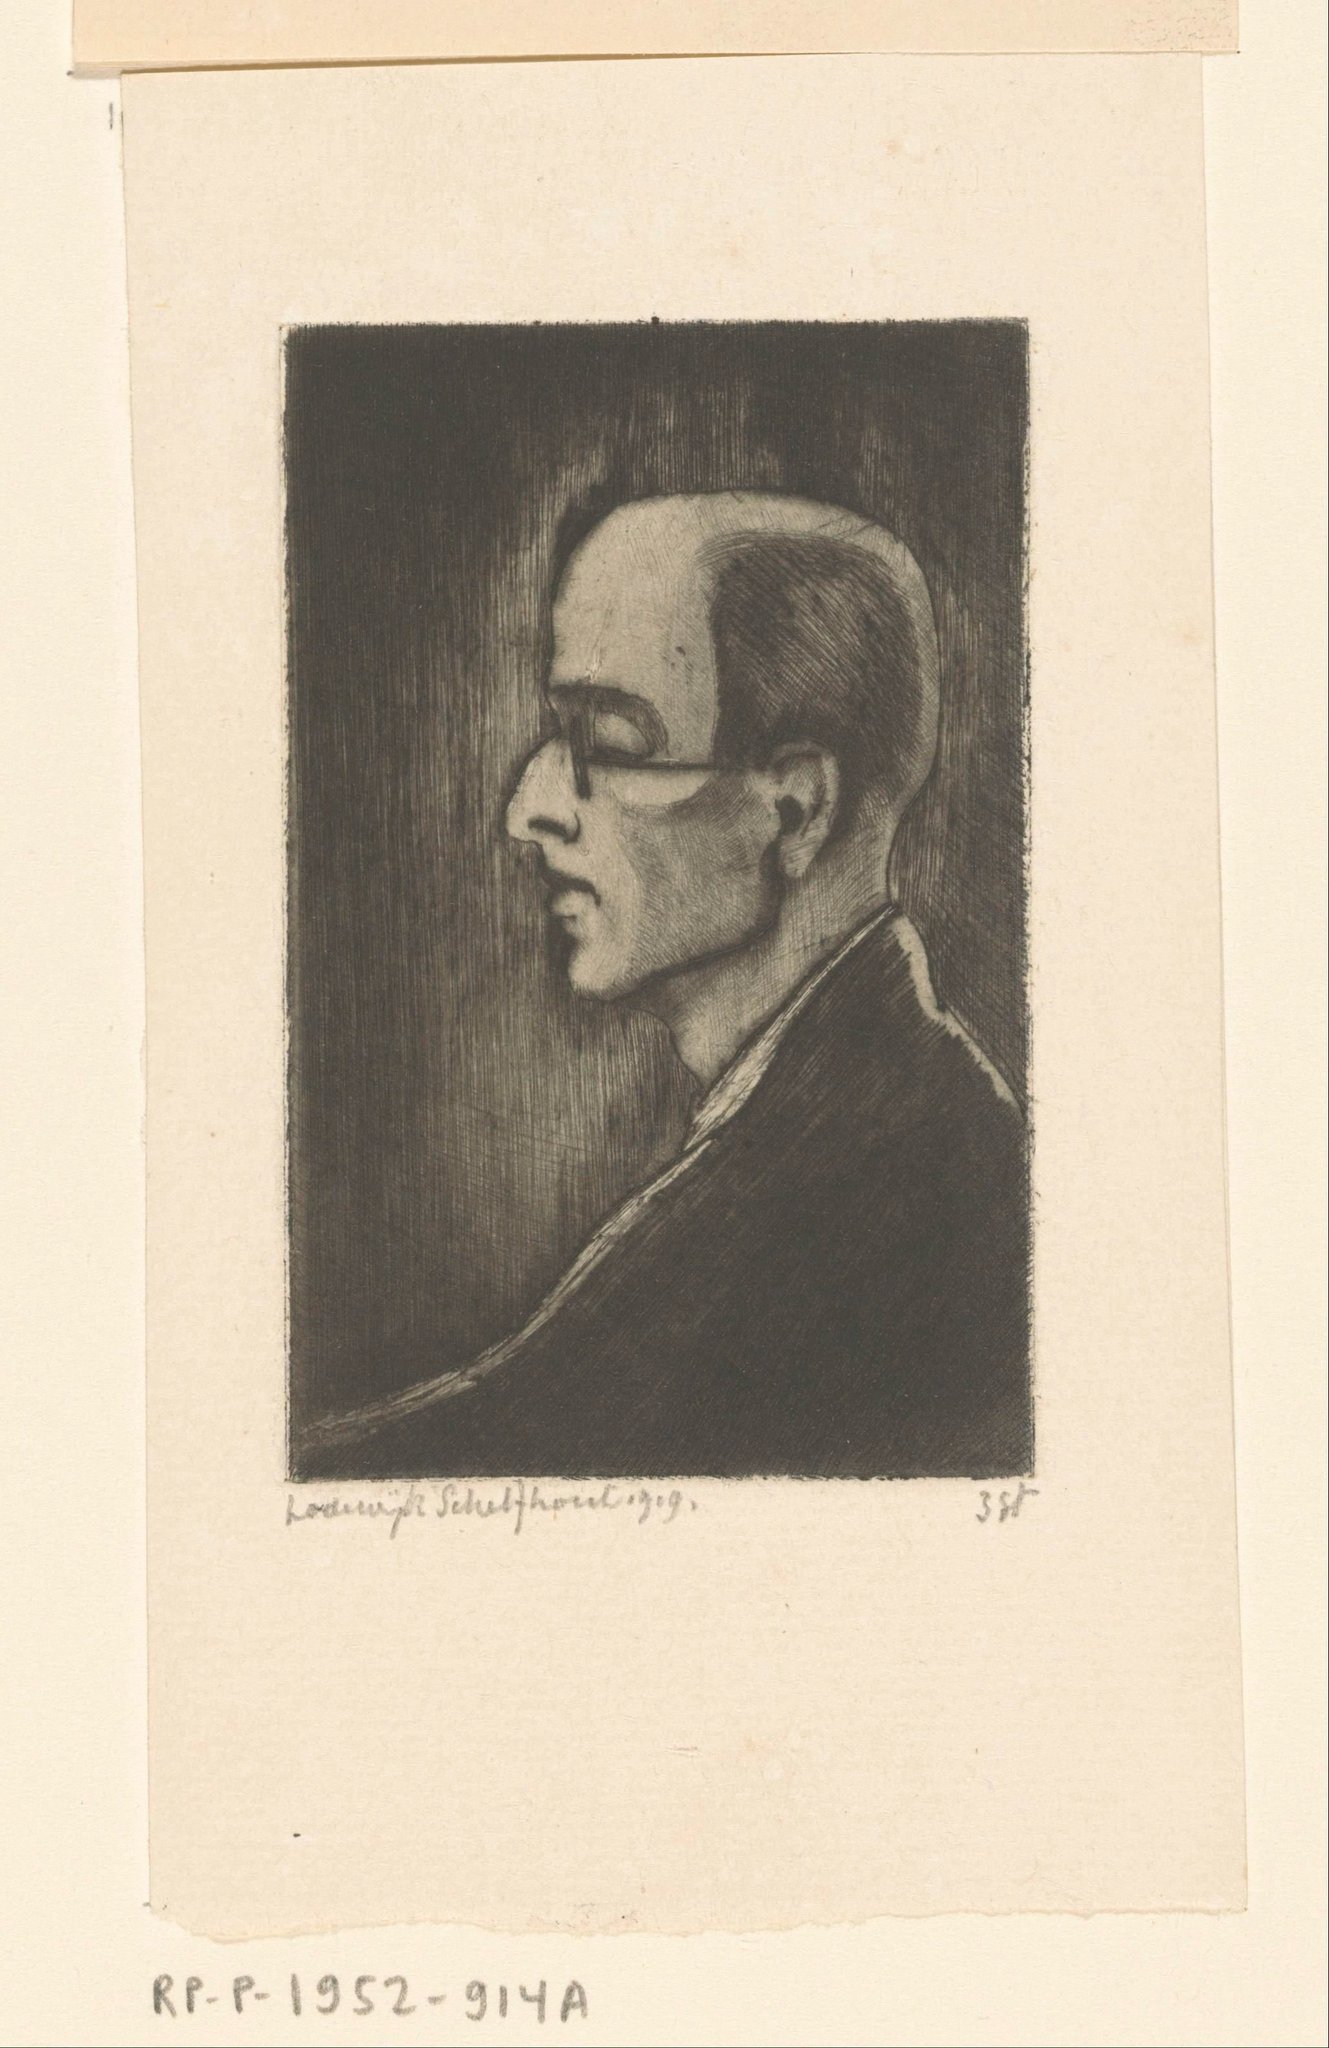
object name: print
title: Portret van Johan Verster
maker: lodewijk schelfhout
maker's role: draughtsman, print maker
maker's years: 1881-1943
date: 1918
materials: paper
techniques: drypoint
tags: blind, blindness, portrait of a musician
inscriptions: collector's mark: Lugt 2760, collector's mark: Lugt 2228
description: Een portret van de blinde pianist Johan Verster, met bril.